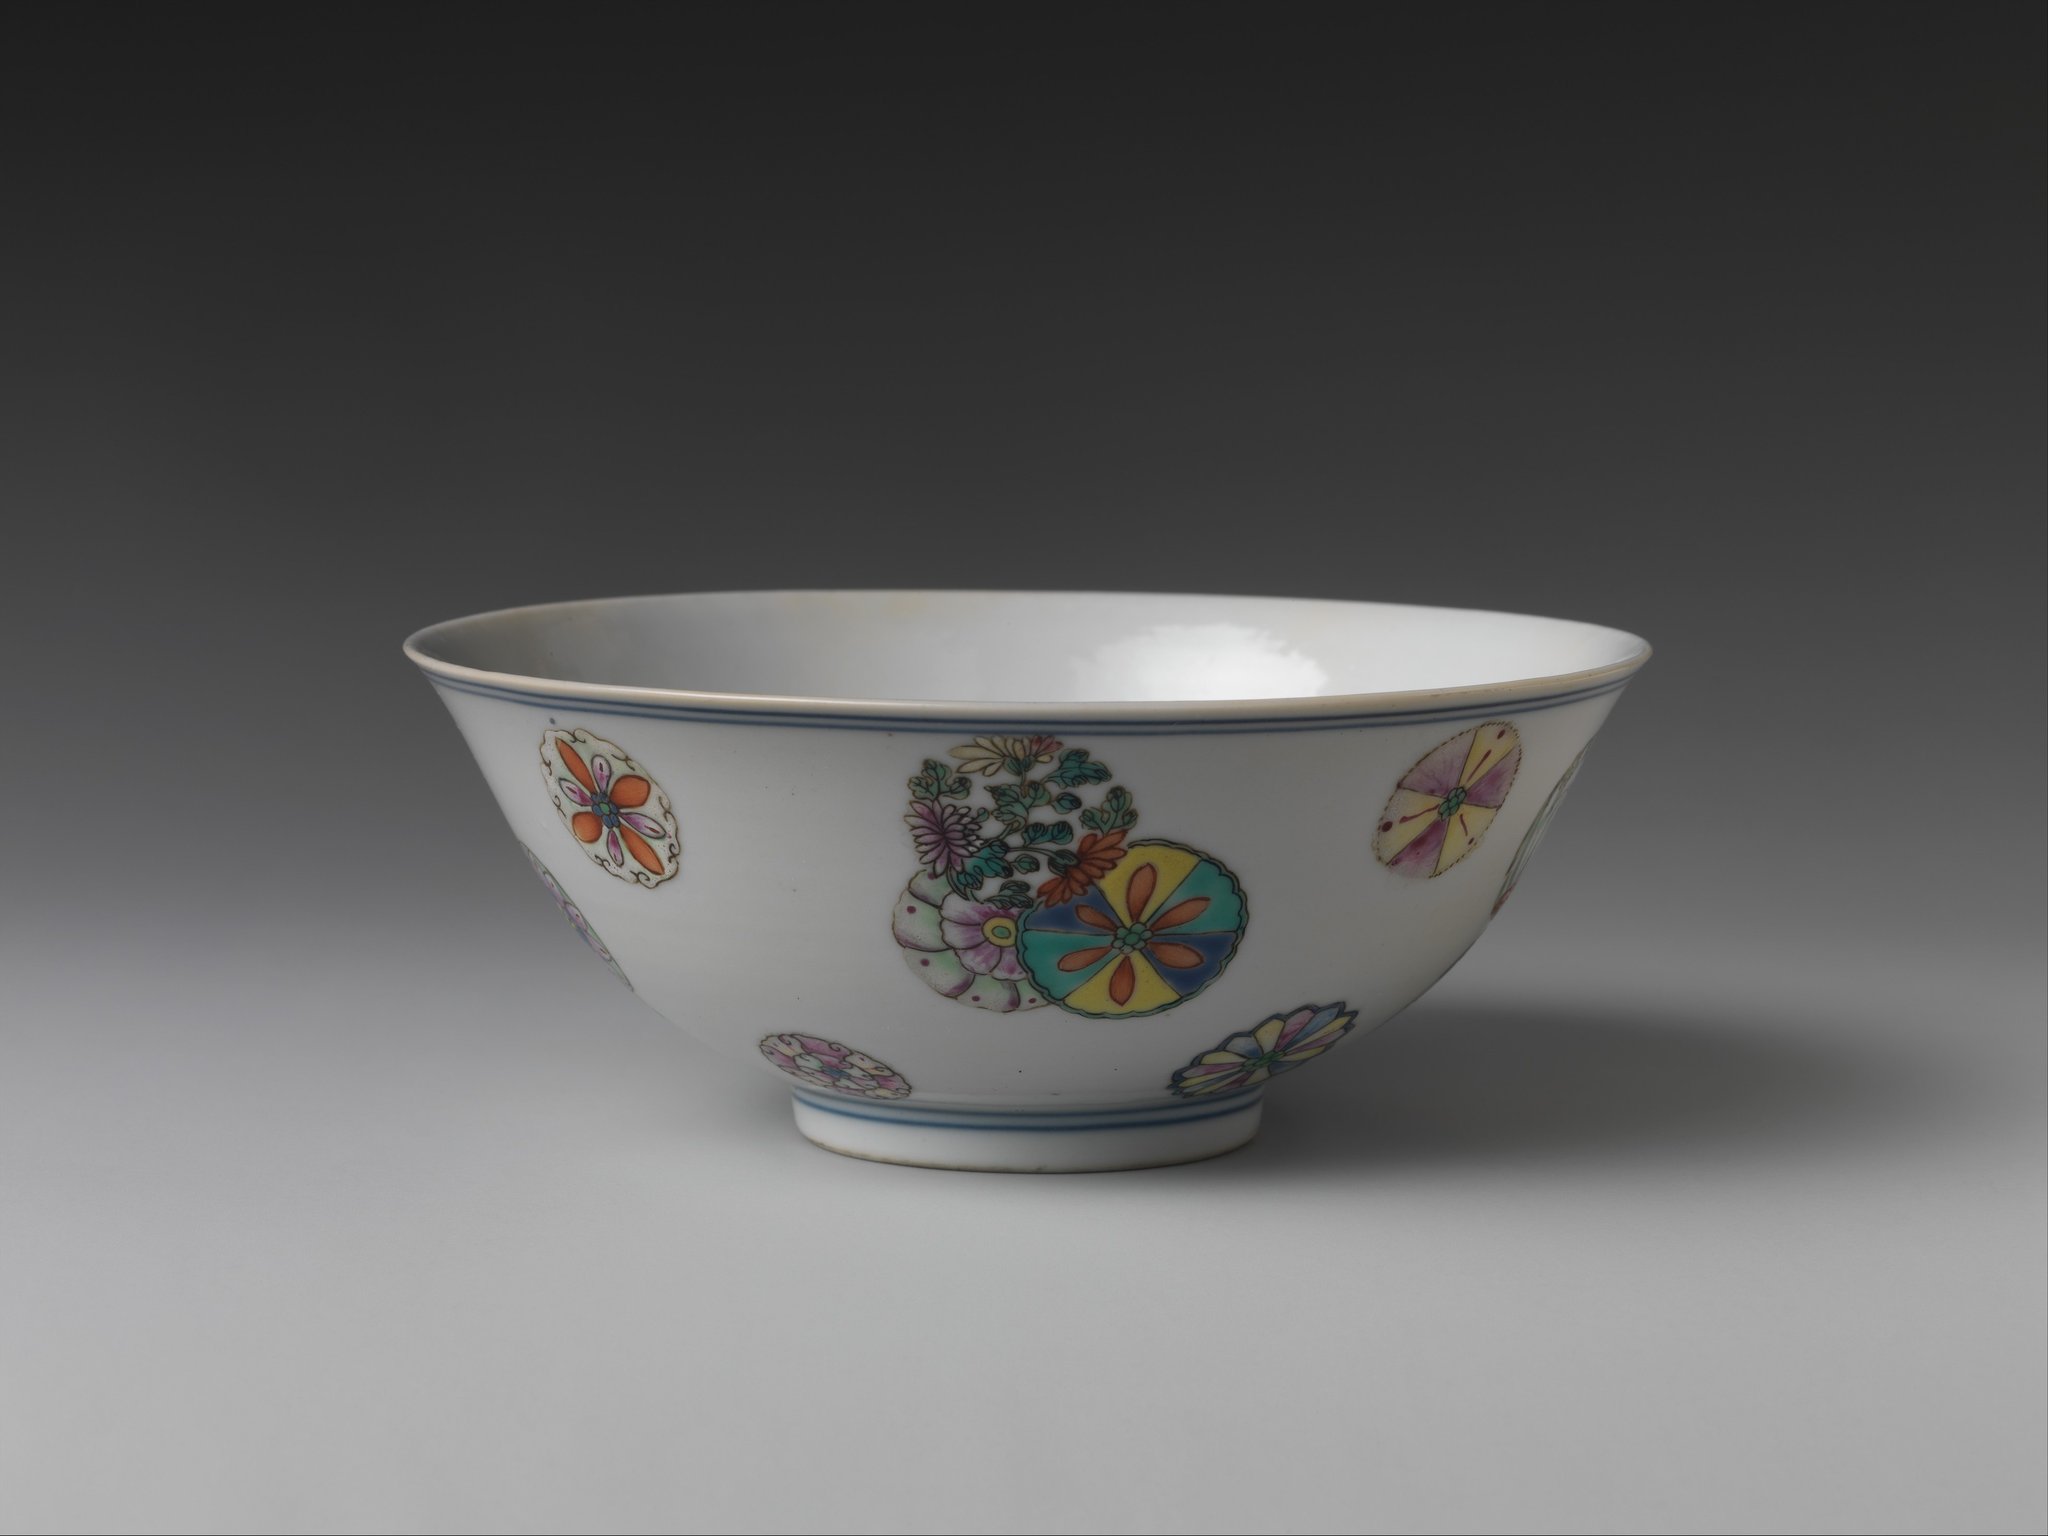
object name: bowl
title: Bowl with decorative medallions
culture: chinese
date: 1796-1820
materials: enamel, porcelain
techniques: overglaze, painting